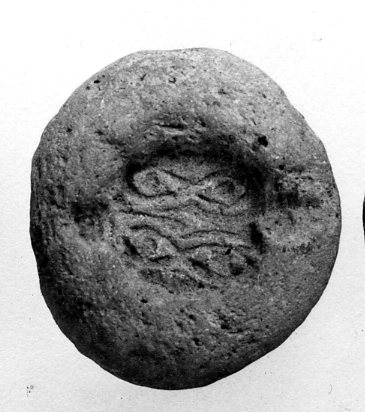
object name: mold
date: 1550-1295 BCE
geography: egypt